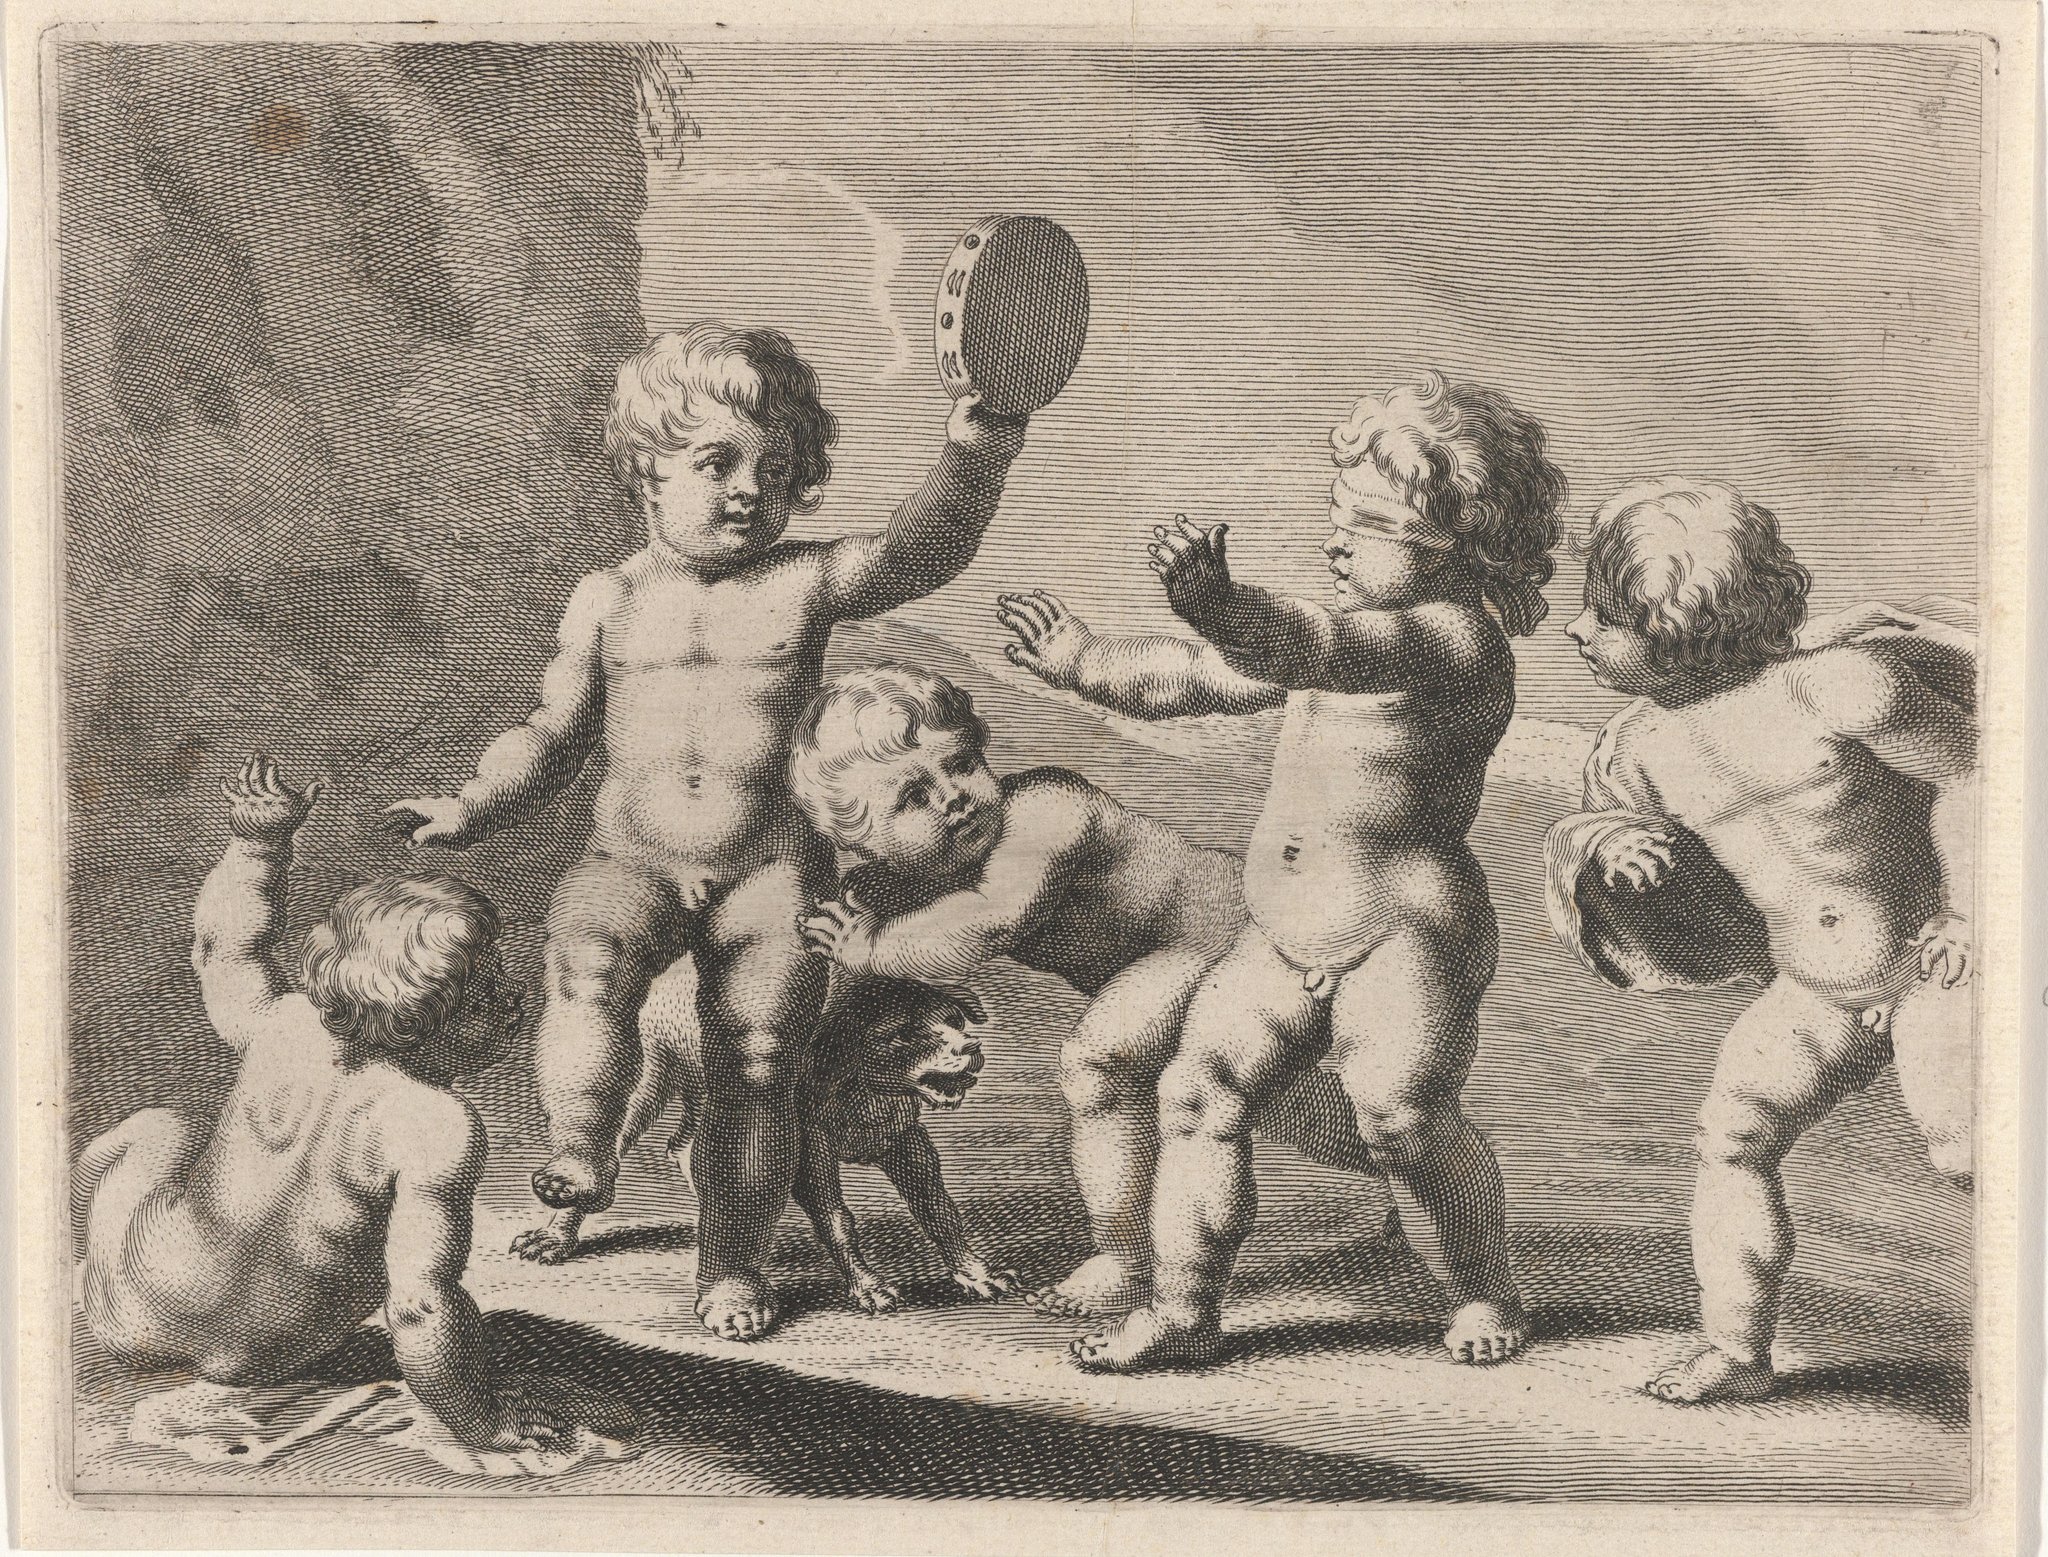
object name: print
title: Kinderen spelen blindemannetje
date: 1640-1655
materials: paper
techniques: engraving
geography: amsterdam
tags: other children's games, tambourine, dog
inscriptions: collector's mark: Lugt 2228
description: Vijf kinderen spelen blindemannetje. Een heeft de blinddoek om, de anderen staan om hem heen. Een jongen slaat op de tamboerijn.